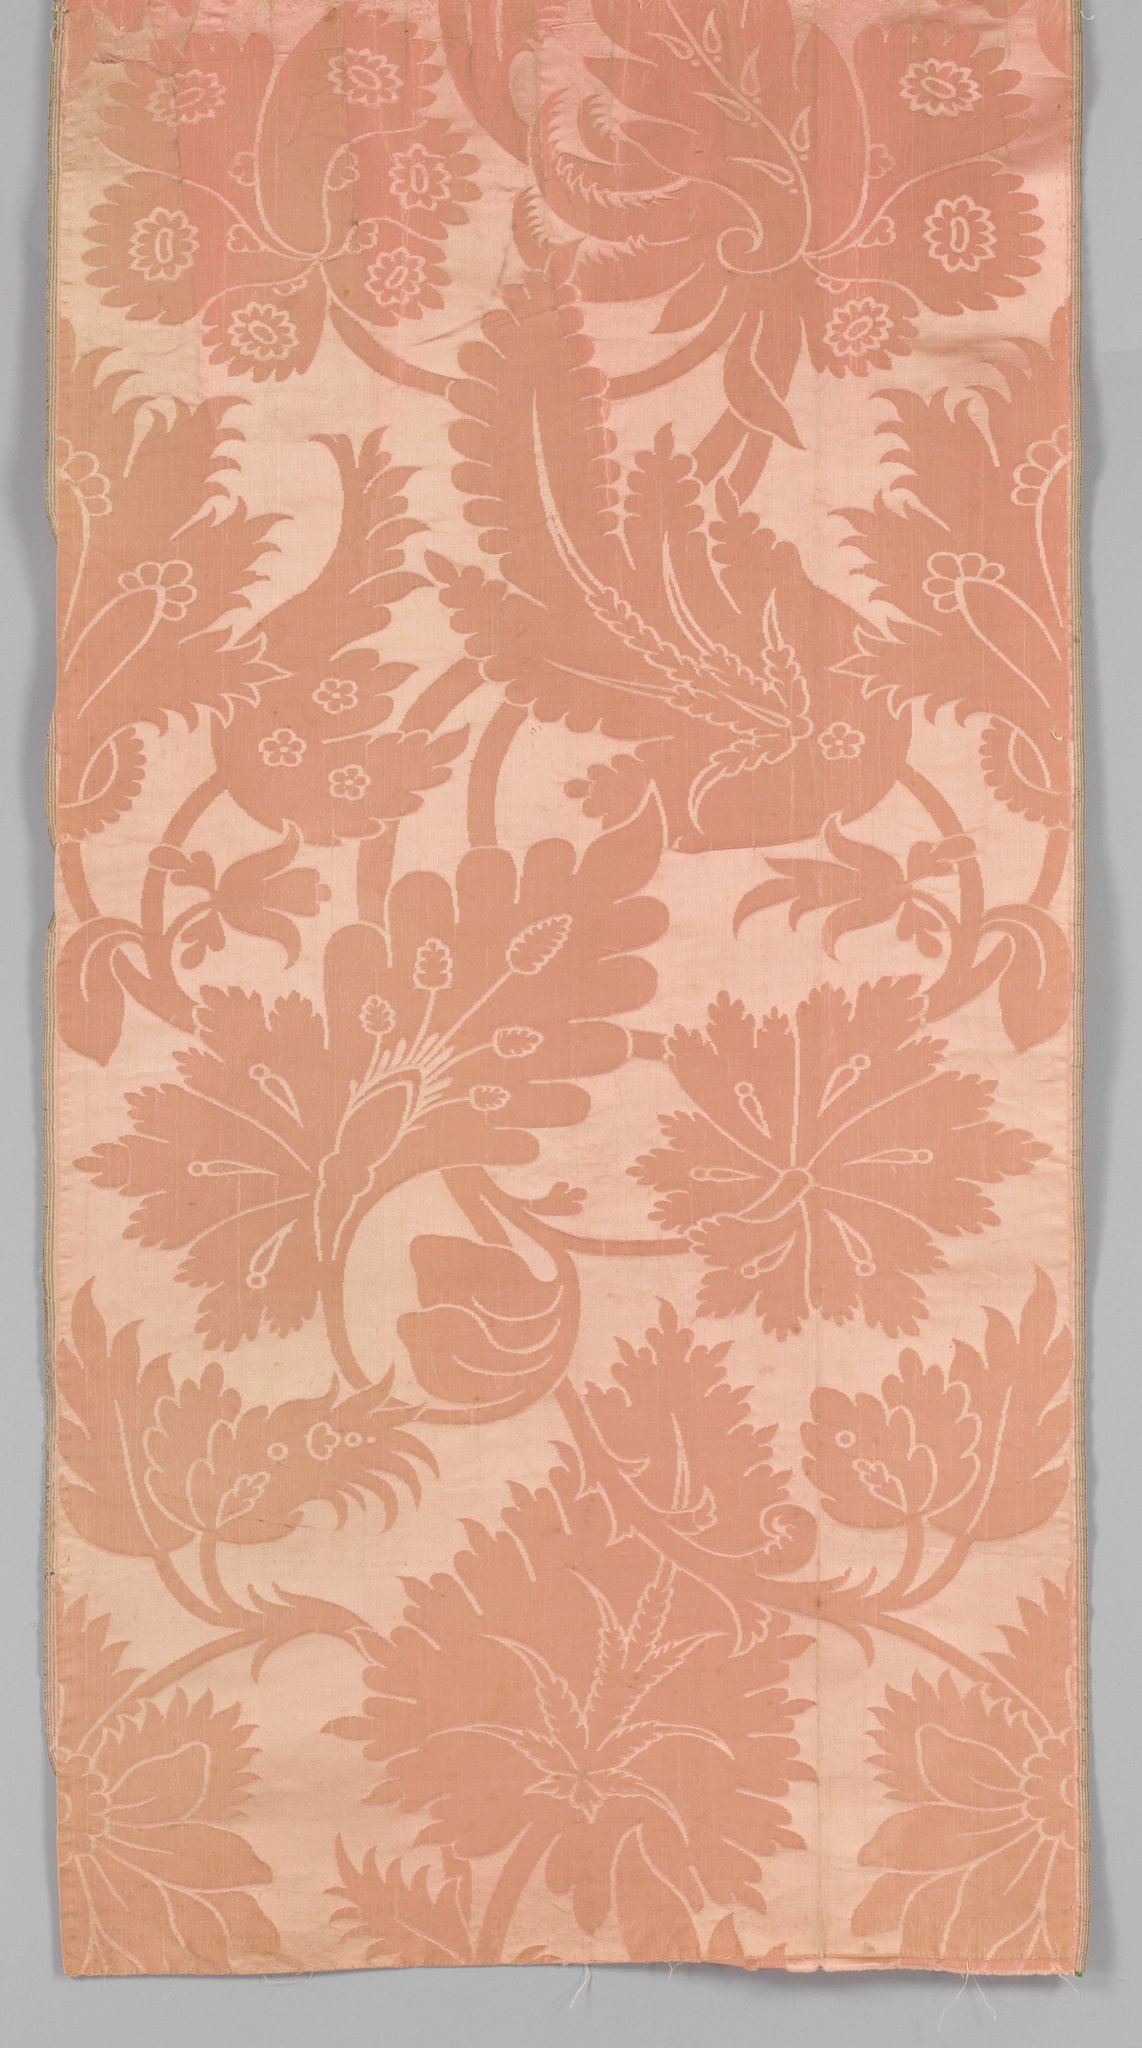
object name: skirt panel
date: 1740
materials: silk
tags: leaves